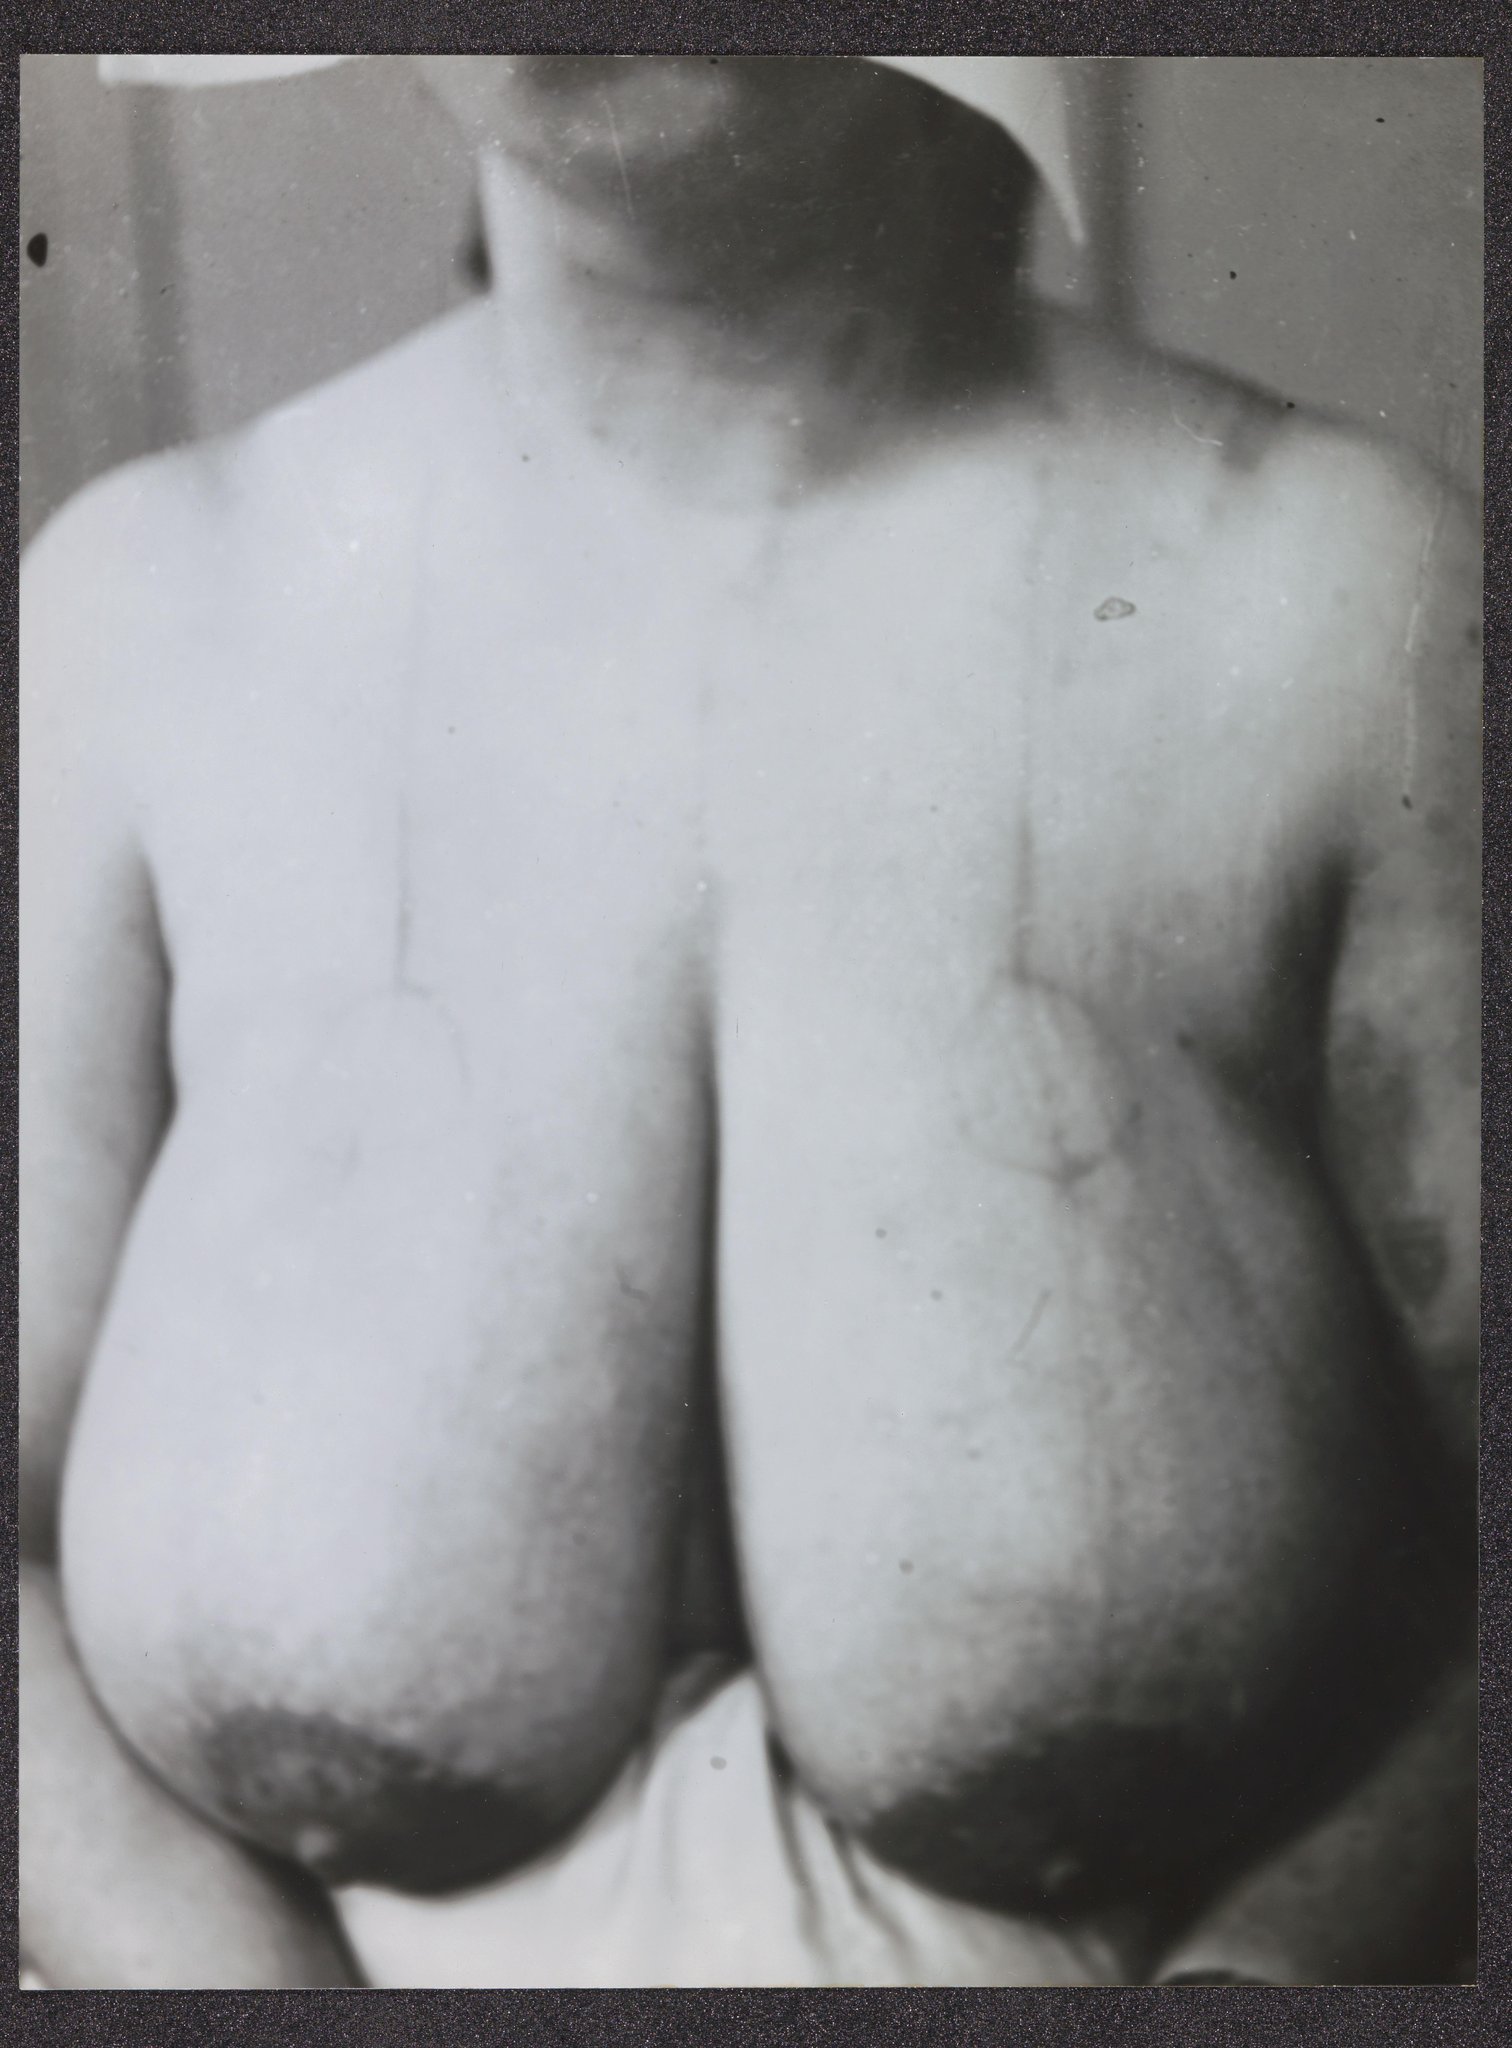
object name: photograph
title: Buste van een vrouw voor een chirurgische ingreep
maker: Anonymous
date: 1930-1964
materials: paper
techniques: gelatin silver print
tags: breasts